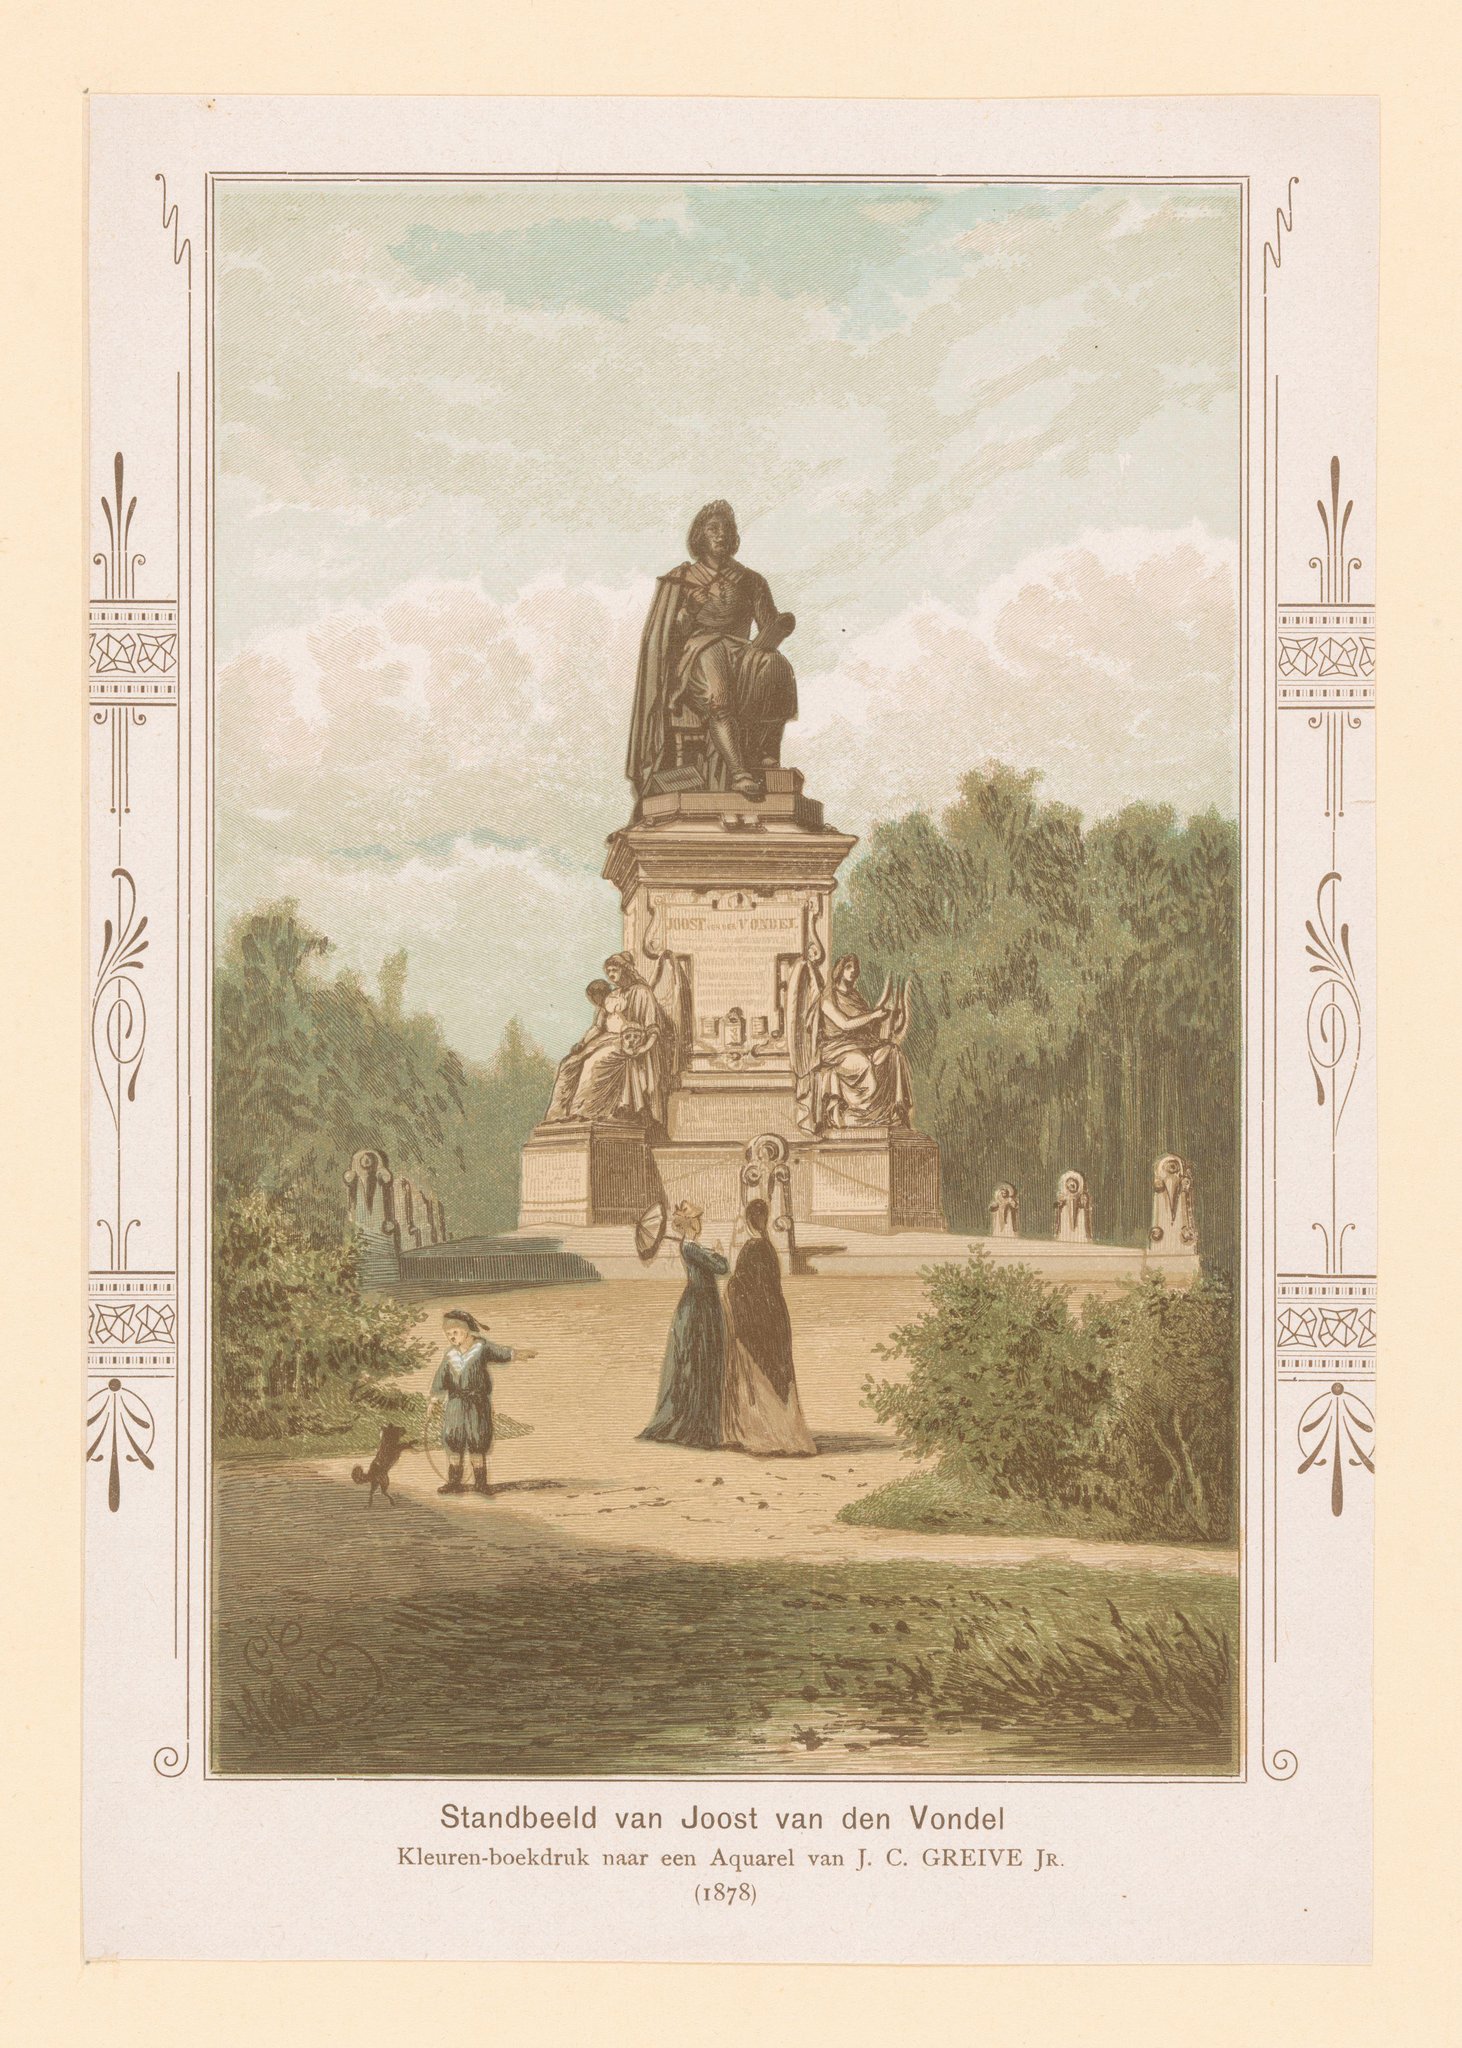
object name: print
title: Gezicht op het Vondelmonument in Amsterdam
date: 1878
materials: paper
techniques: wood engraving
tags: cologne, joost van den vondel, park, monument, statue